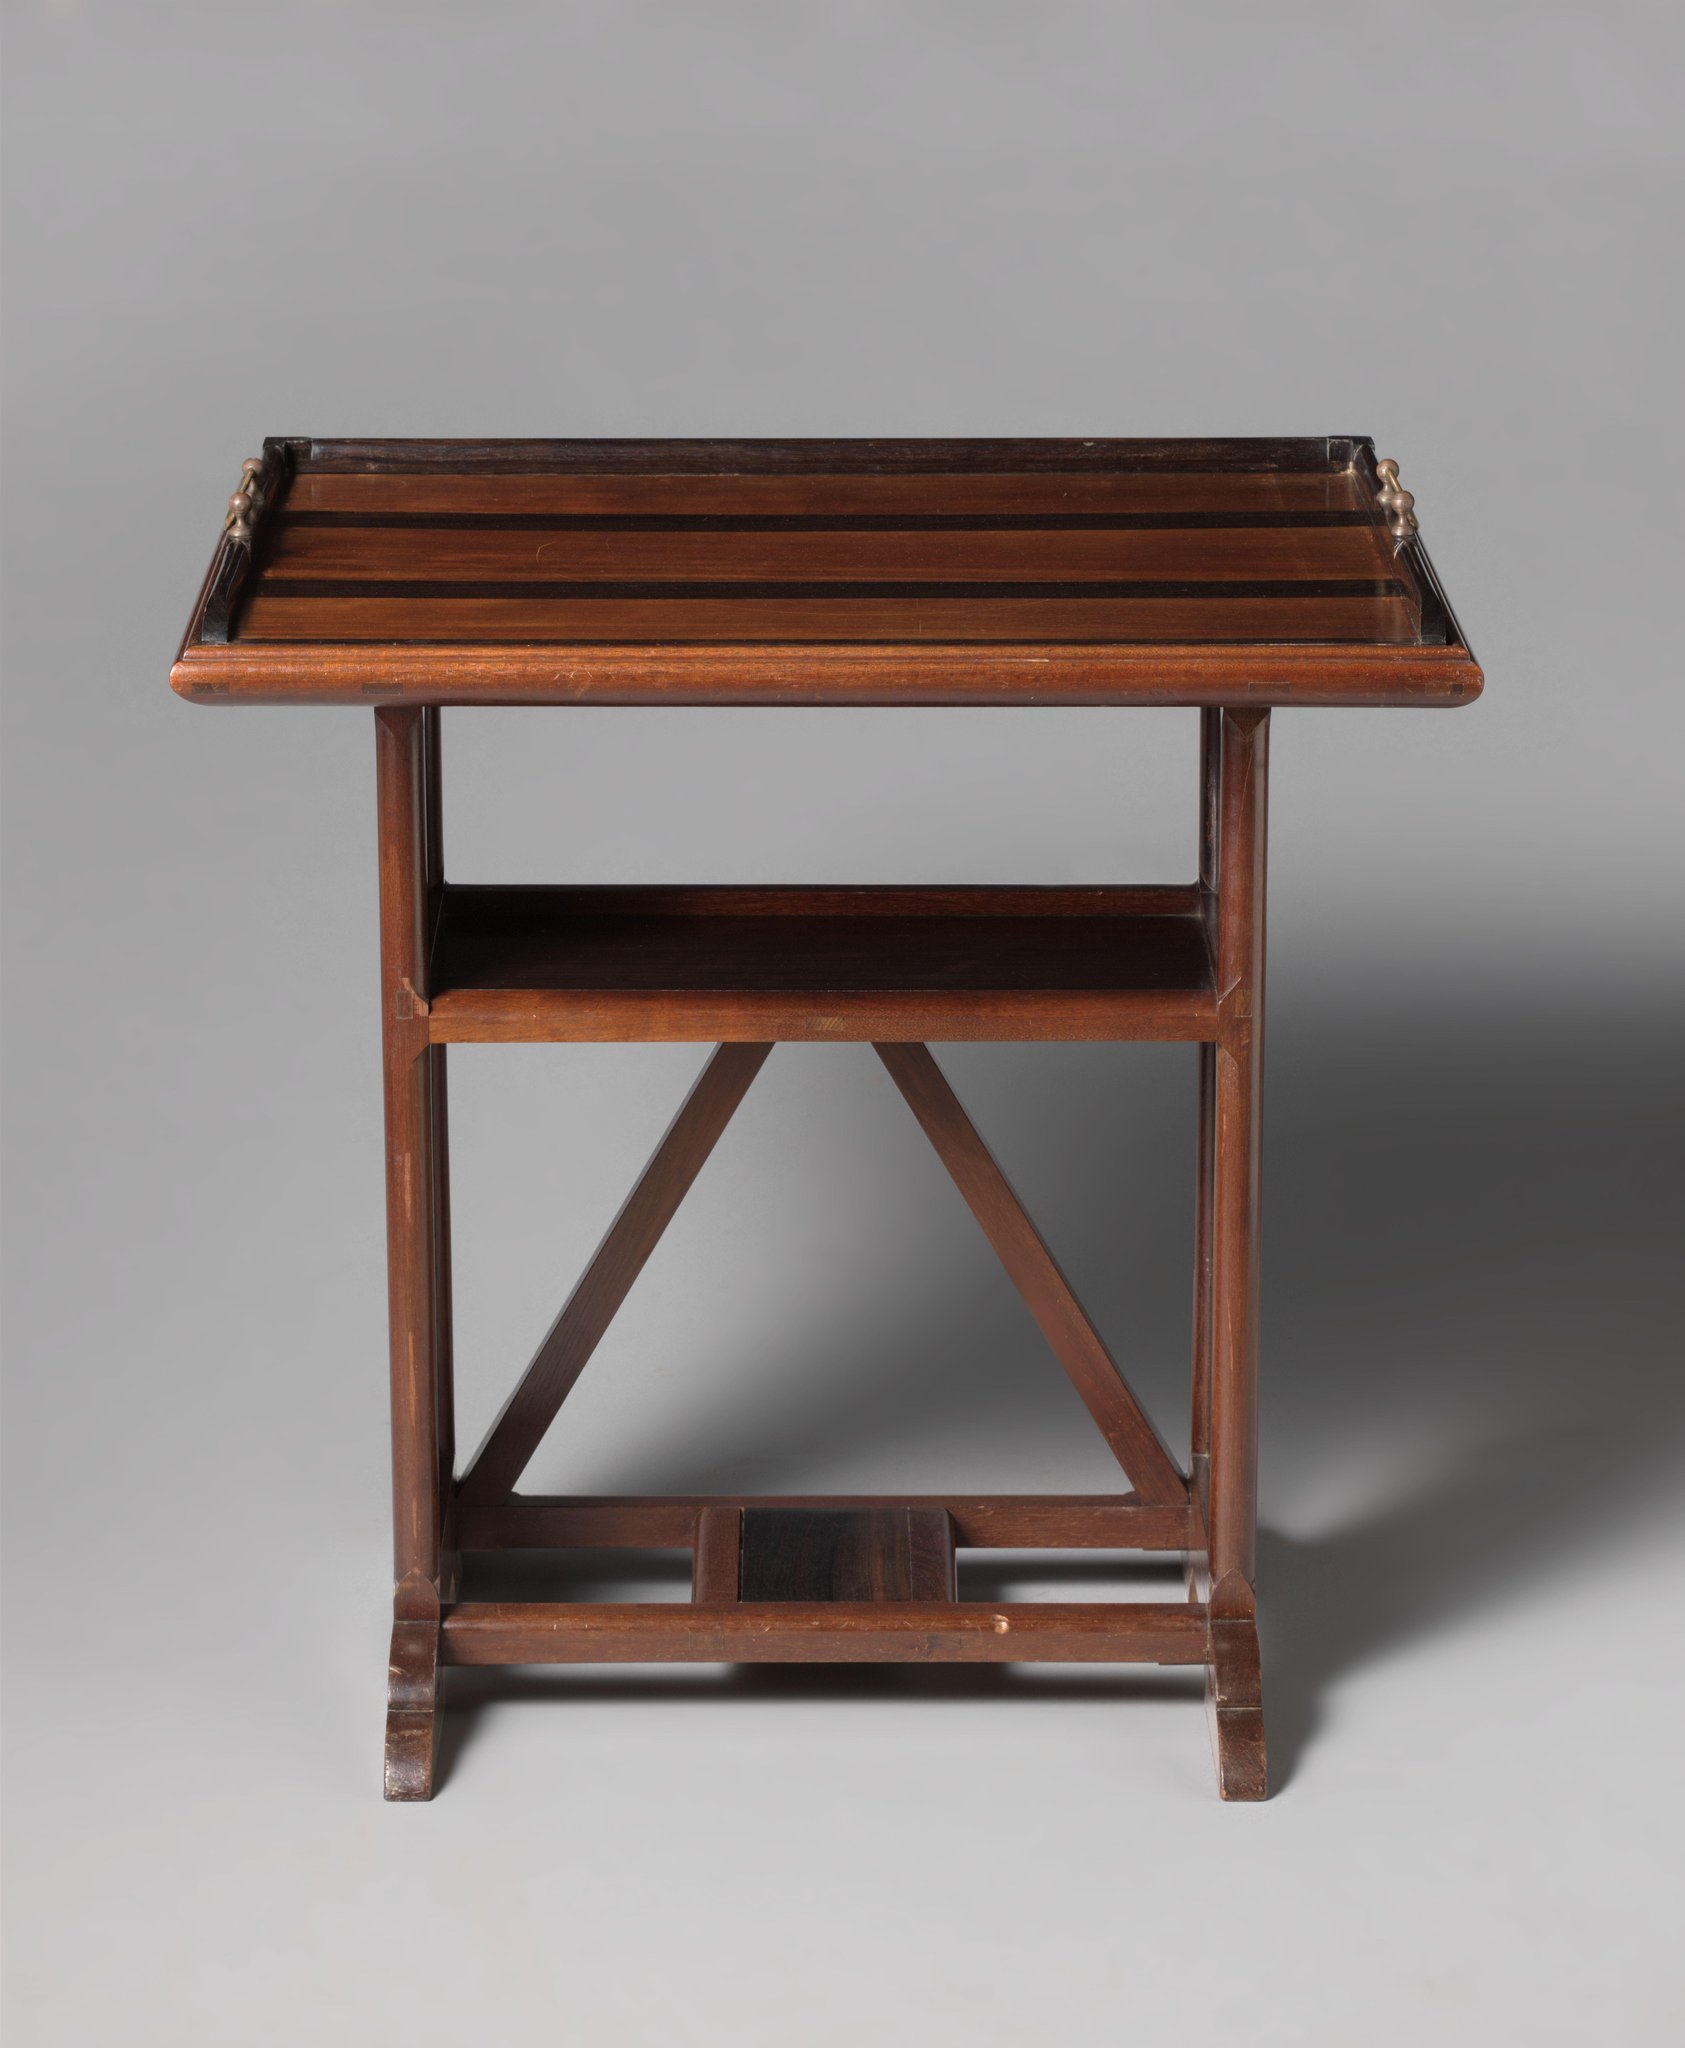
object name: tea table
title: Theetafel met afneembaar dienblad en met zijwanden opengewerkt in een bonenmotief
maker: theo nieuwenhuis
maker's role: designer, draughtsman, print maker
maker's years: 1866-1951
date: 1900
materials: wood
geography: amsterdam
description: Theetafel van eiken- en mahoniehout rustend op vier afgeronde, platte poten die op schuifdoppen rusten. De poten worden onderling verbonden door middel van een H-vormig kruis met een dubbele dwarsstreep waarbinnen een paneel is aangebracht. De ruimte tussen de twee zijstijlen is opgevuld met twee panelen boven elkaar die zijn opengewerkt in een bonenmotief. Op beide panelen zijn twee peulen ingelegd met een lichtere houtsoort. Ter hoogte van het midden is een tussenblad aangebracht. Het tussenblad wordt door middel van twee schuingeplaatste stutten verbonden aan de regel tussen de twee poten. Het bovenblad is aan de onderzijde door middel van consoles verbonden aan de poten. Het bovenblad bestaat uit een open raamwerk met opstaande randen. Hierbinnen valt een uitneembaar dienblad met aan drie zijden opstaande randen. Op de randen aan de zijkanten is een handgreep van koper bevestigd.